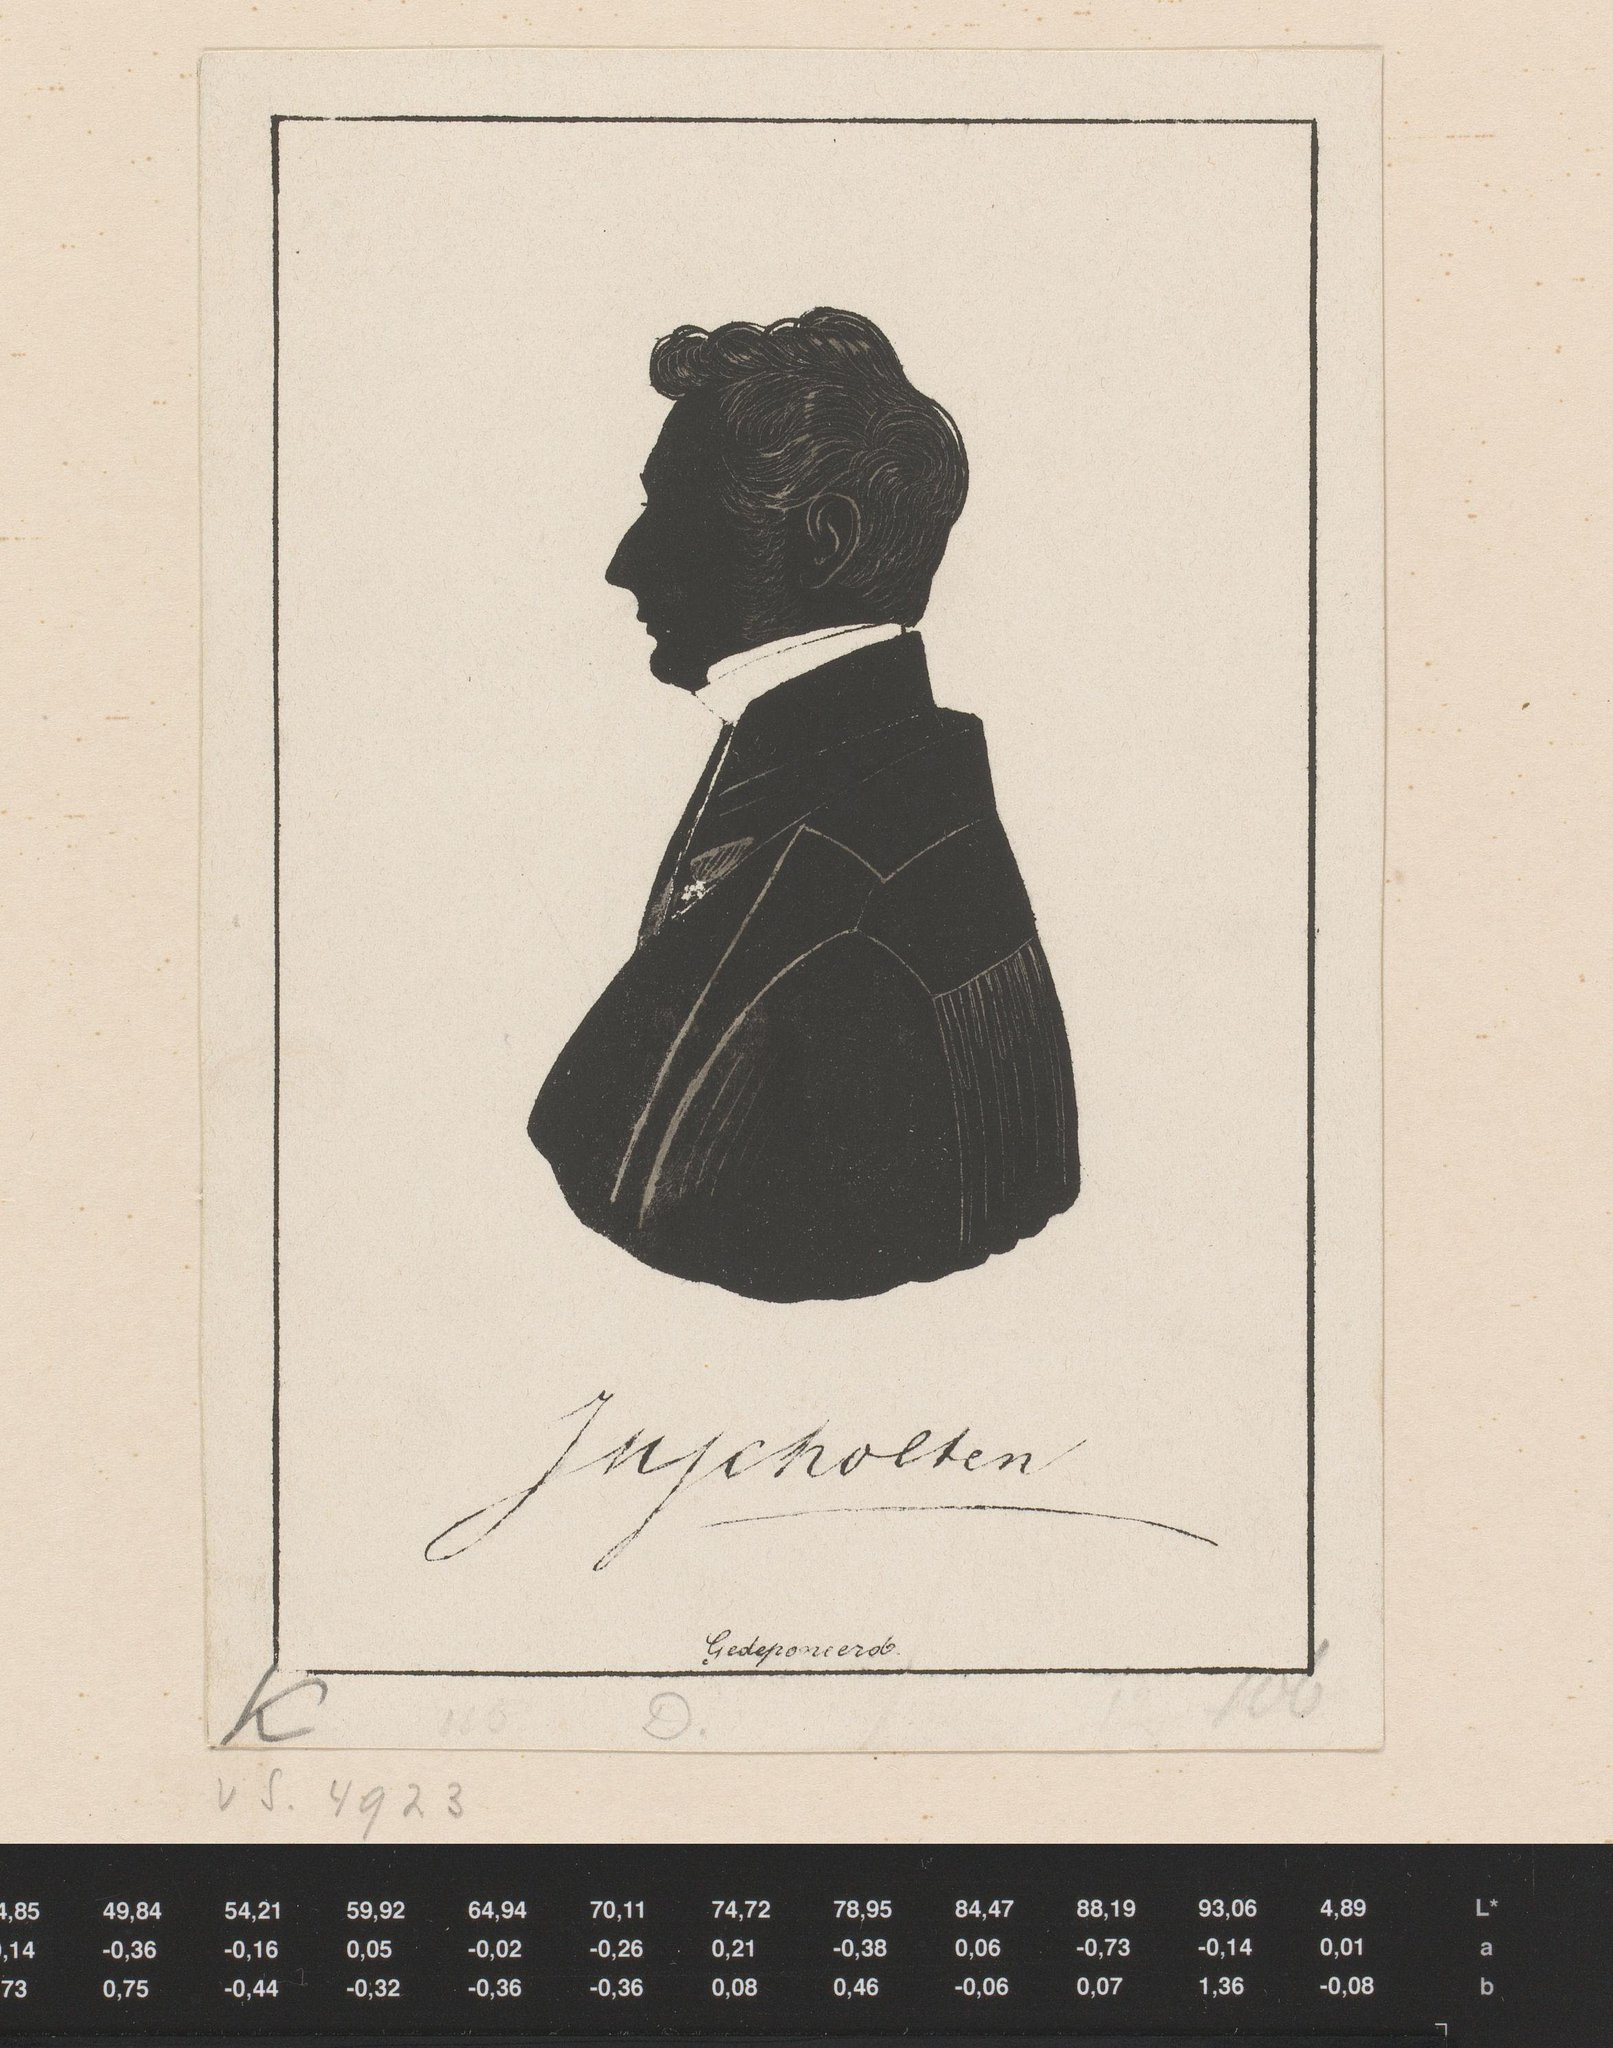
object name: print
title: Silhouetportret van Johannes Henricus Scholten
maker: weduwe pieter barbiers (iv)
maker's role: publisher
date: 1837-1862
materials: paper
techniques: hand coloring, lithograph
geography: zwolle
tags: leiden, historical persons, functionaries and dignitaries ~ protestant churches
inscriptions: : ‘Gedeponeerd.’, collector's mark: Lugt 2228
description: Met facsimile handtekening van de geportretteerde.